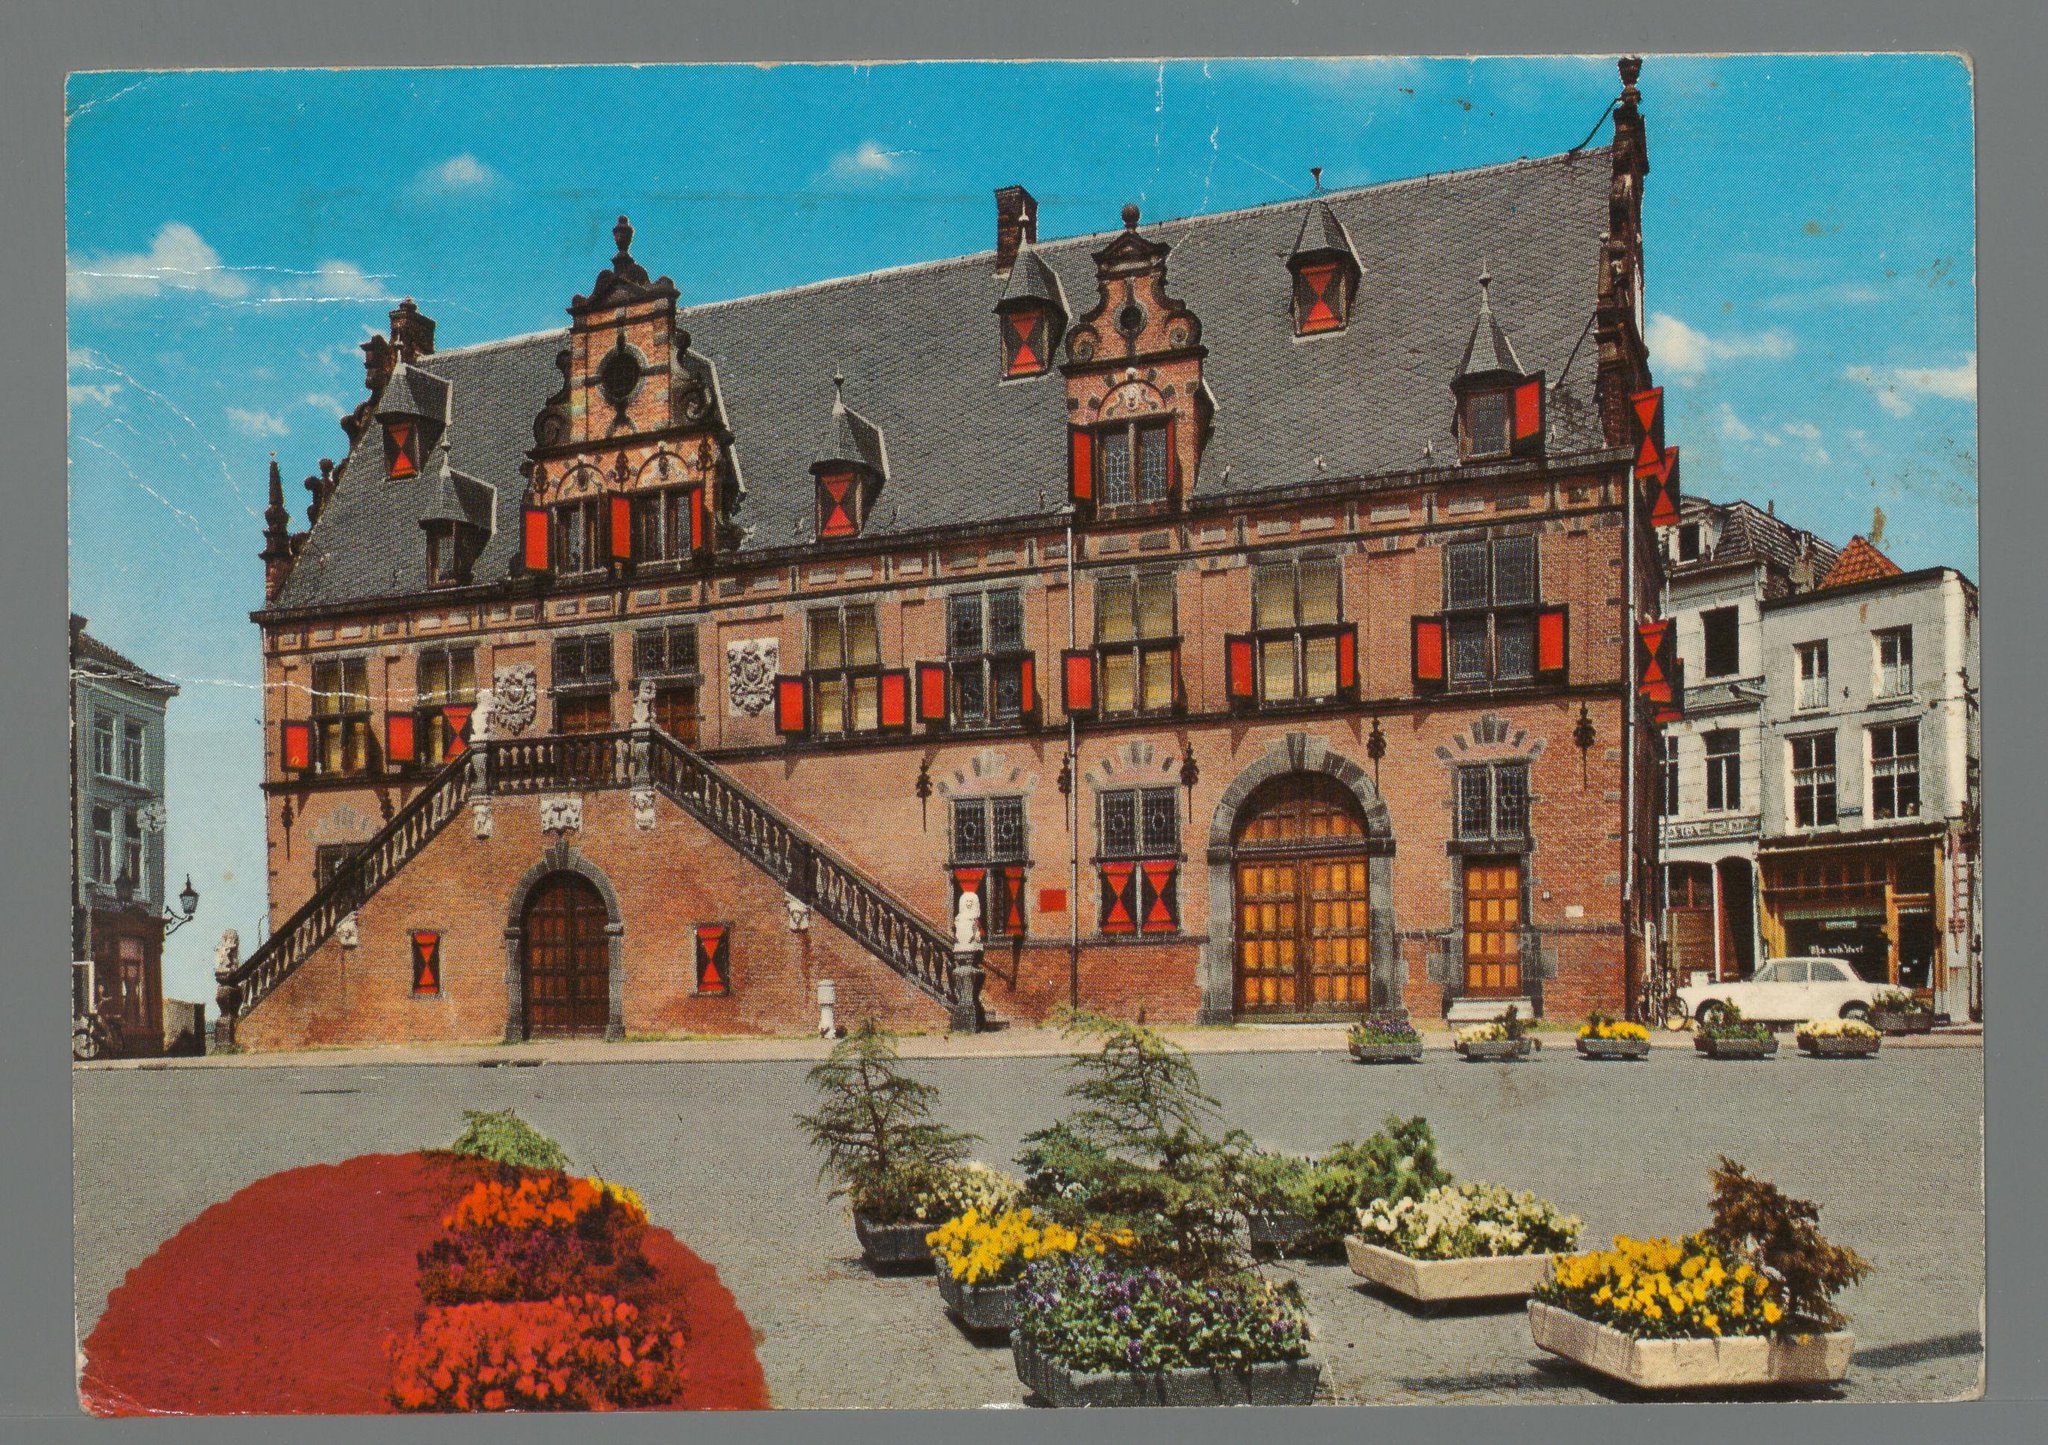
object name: photomechanical print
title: Nijmegen. Waaggebouw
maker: Anonymous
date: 1960-1979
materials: cardboard, ink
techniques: offset printed, writing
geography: nijmegen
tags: square, place, circus, etc., weigh-house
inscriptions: poststempel, verso, gestempeld